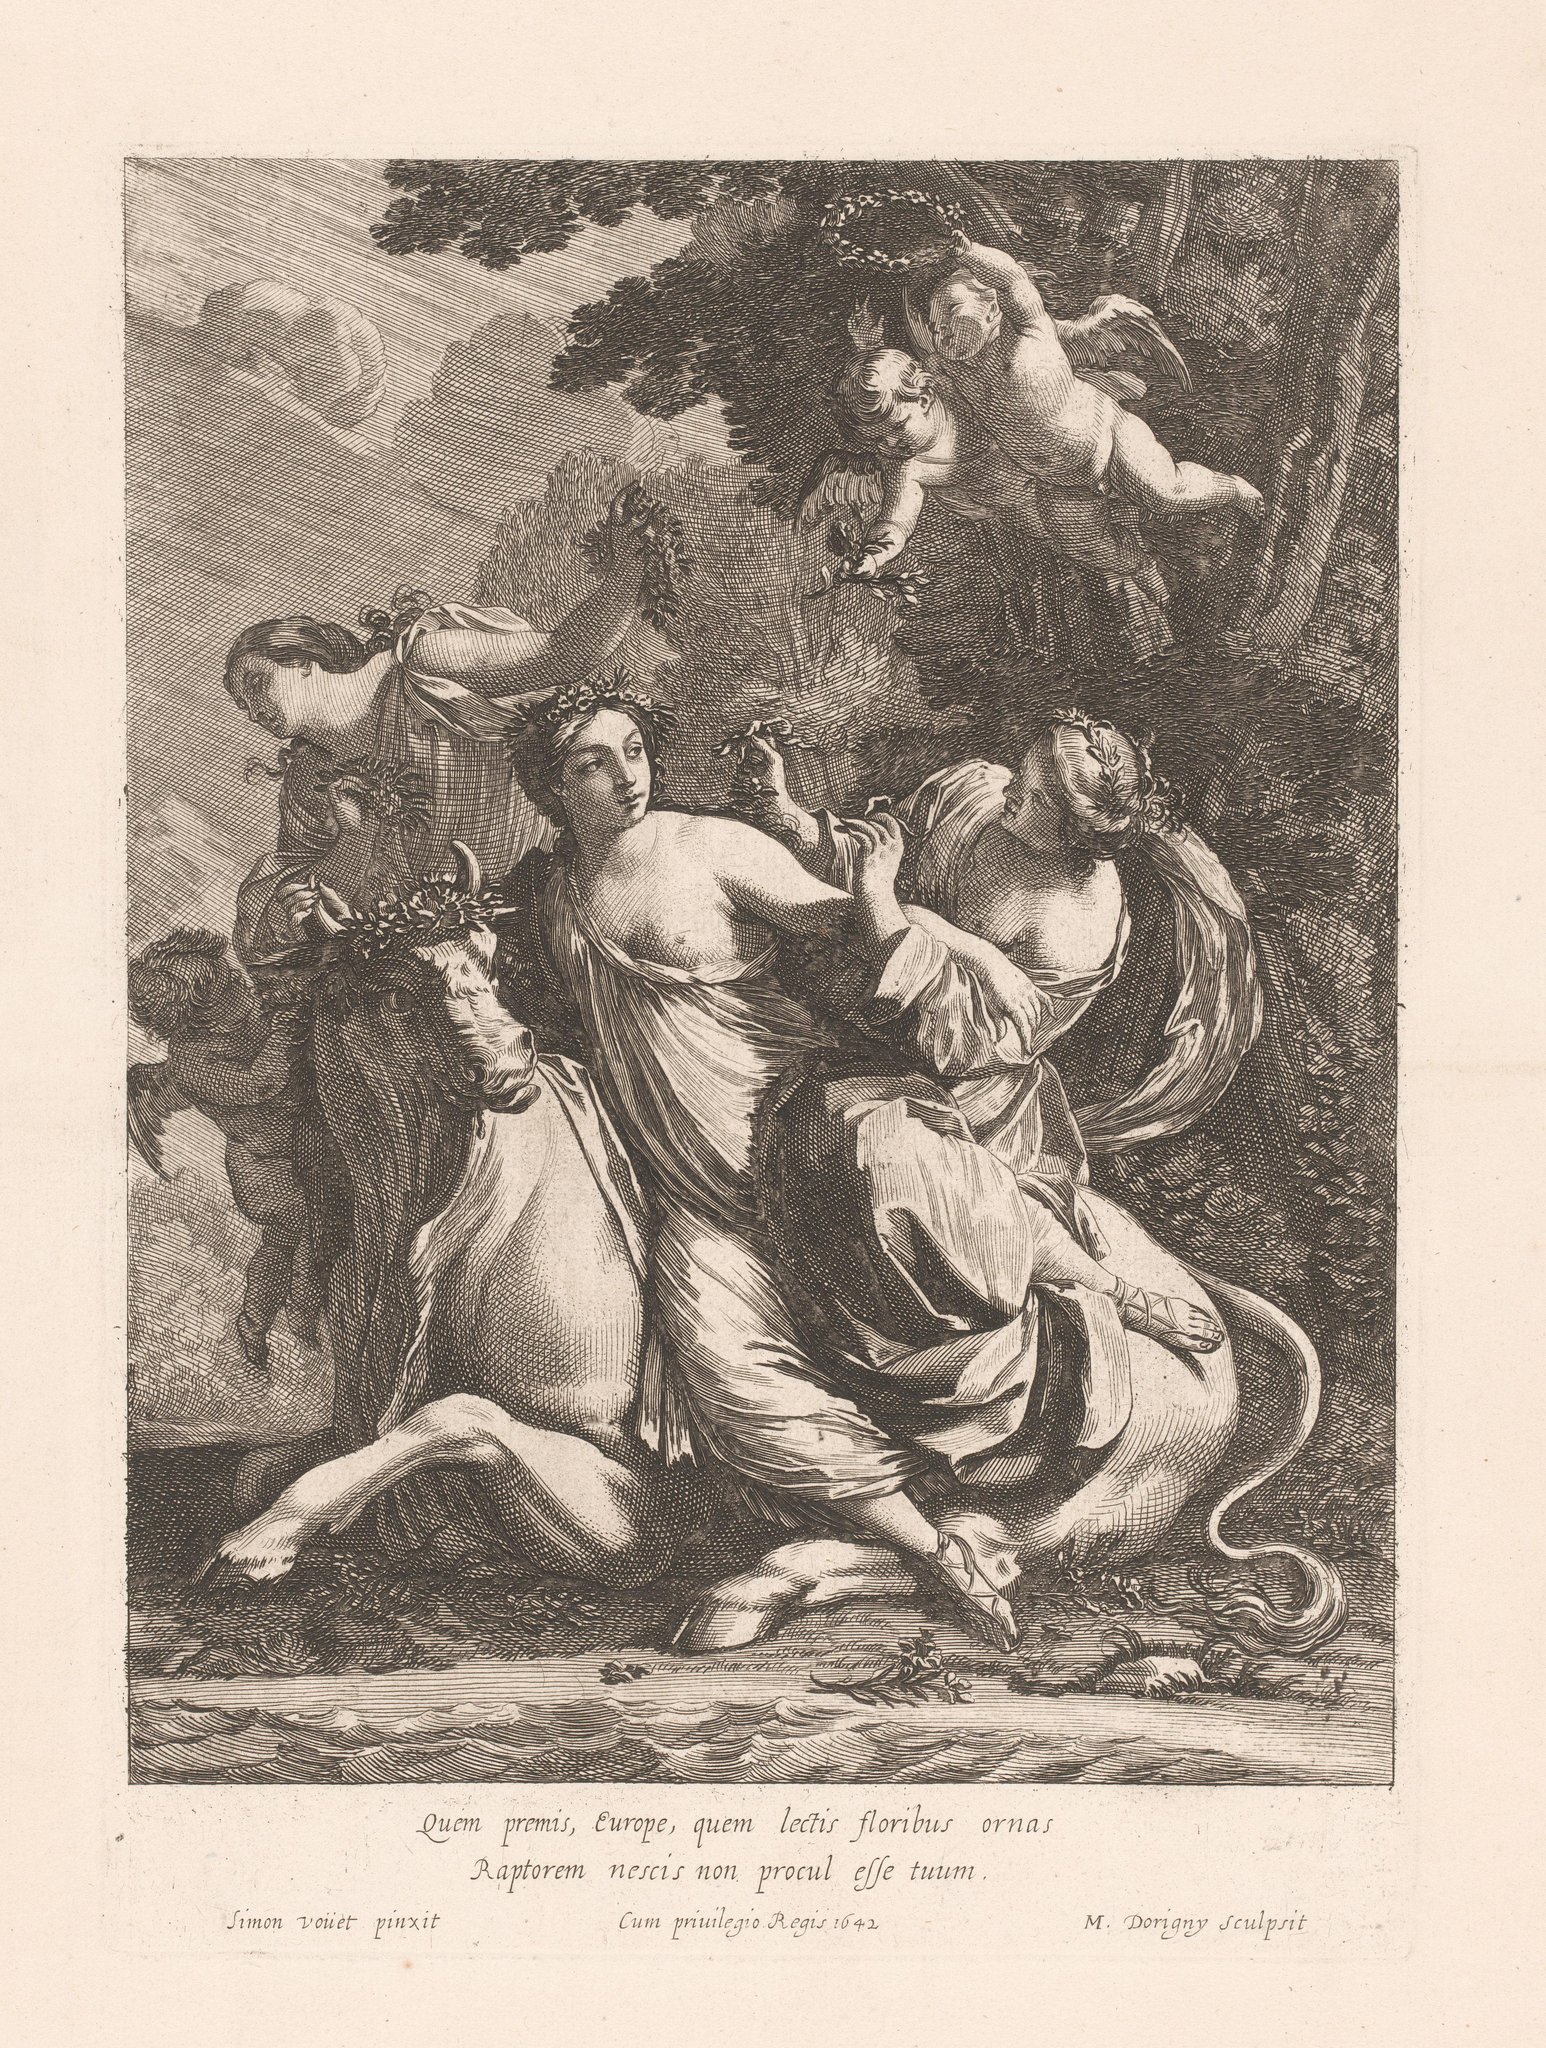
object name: print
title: Ontvoering van Europa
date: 1642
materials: paper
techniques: engraving, etching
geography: france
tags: jupiter, usually in the shape of a white bull, abducts europa and carries her across the water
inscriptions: collector's mark: Lugt 2228, watermark